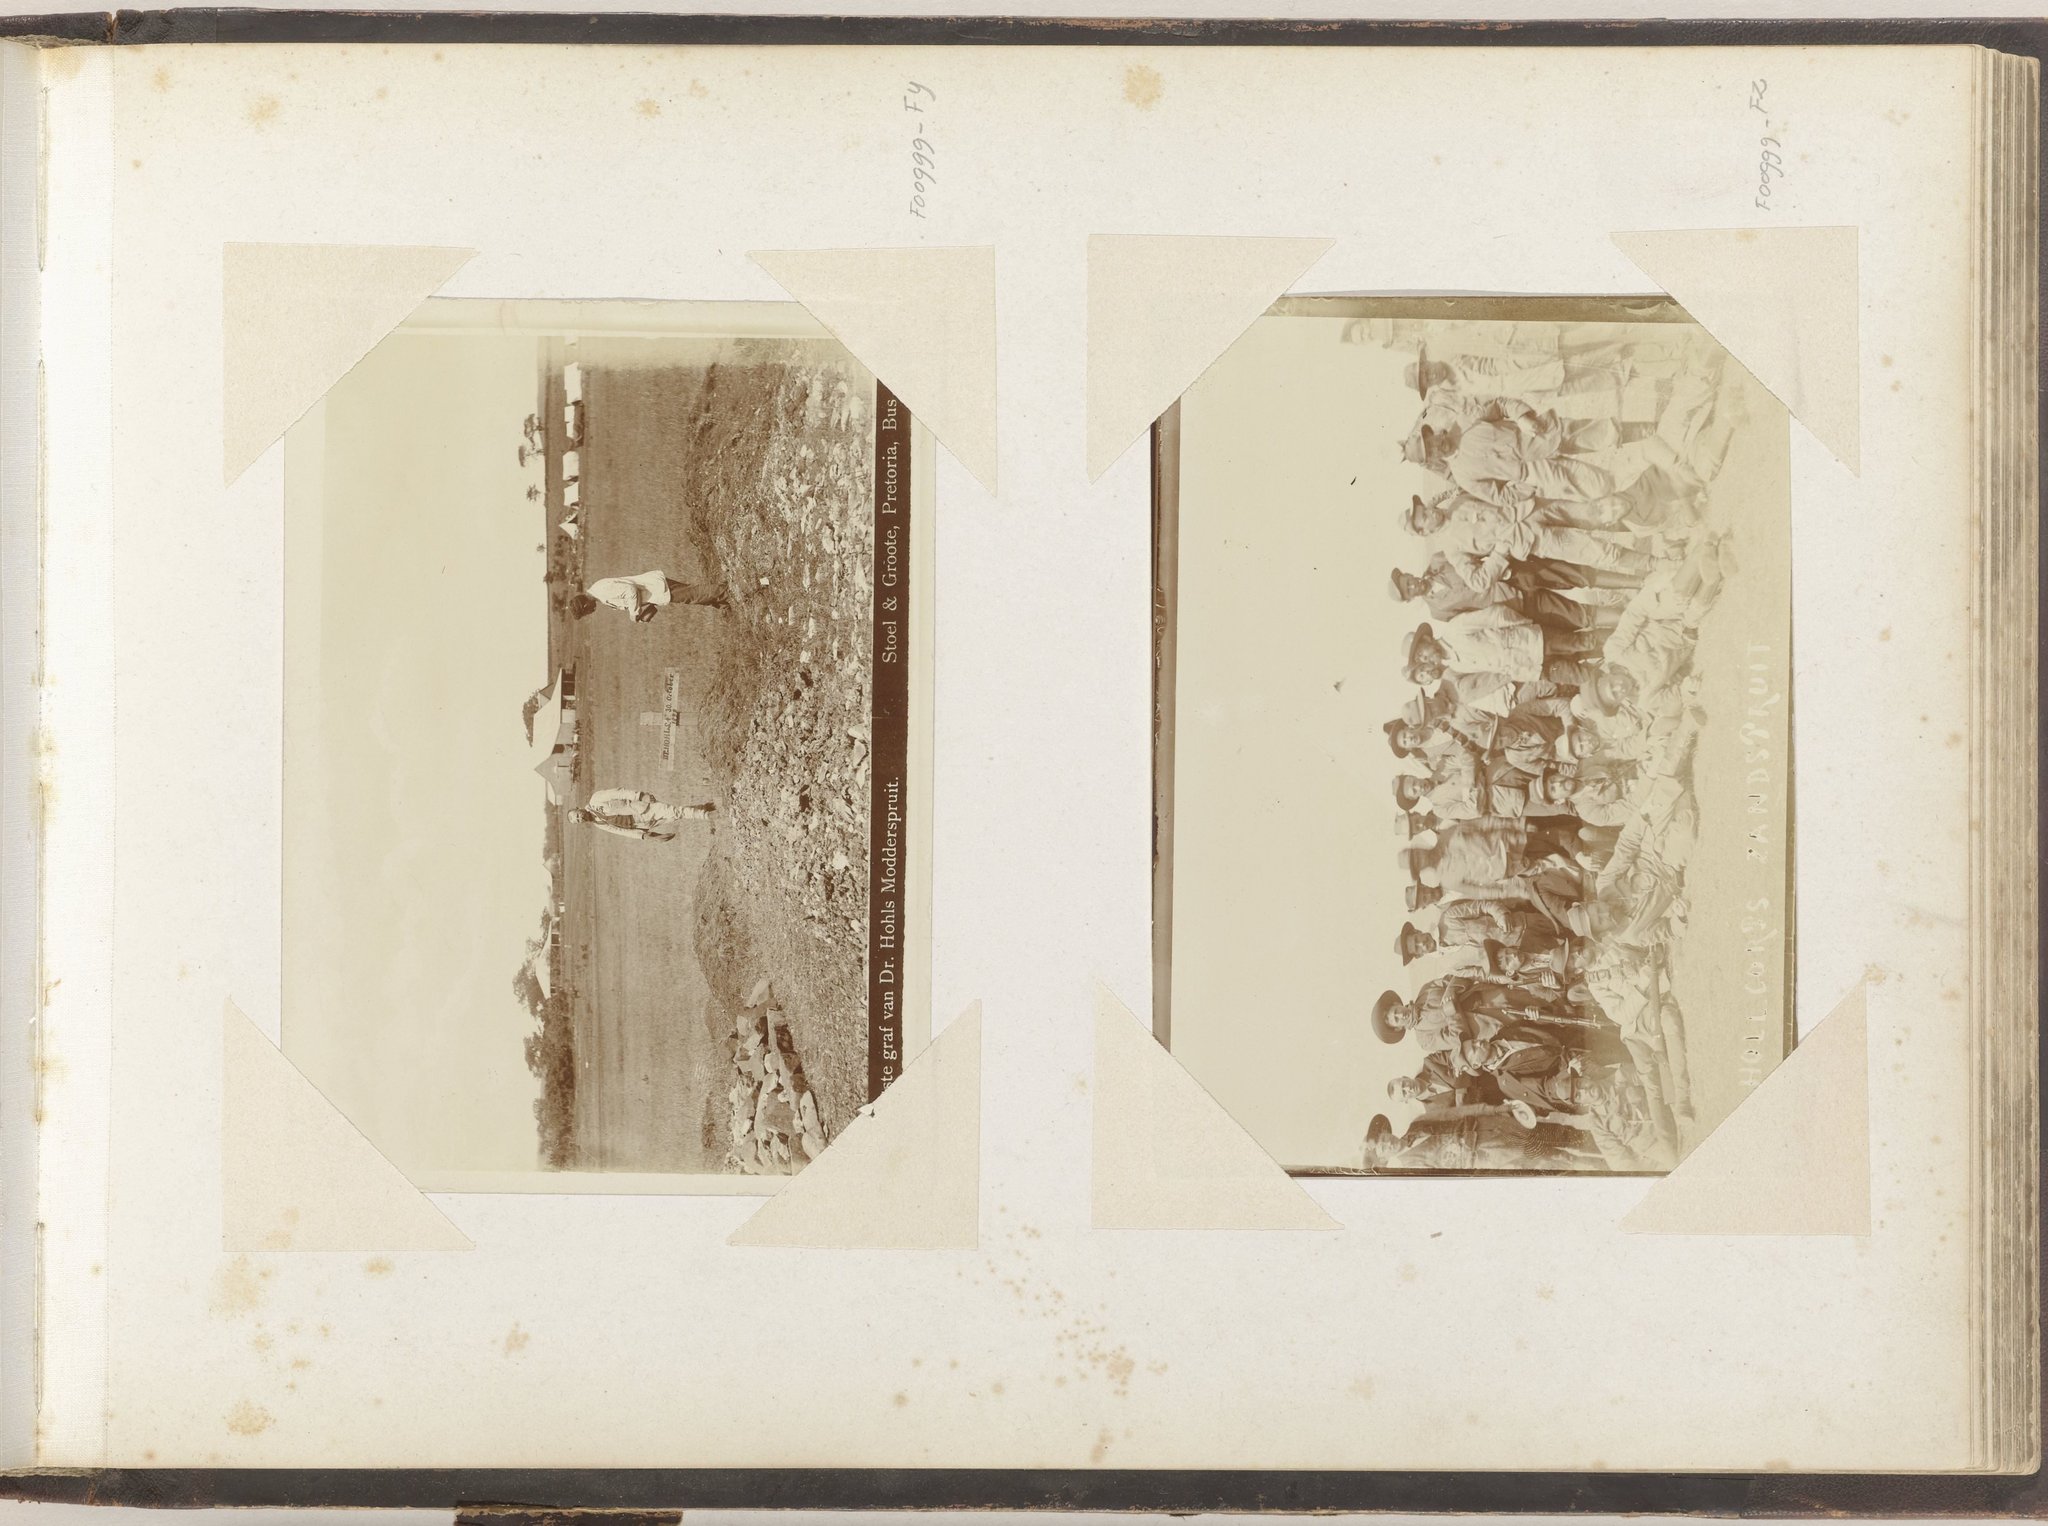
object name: photograph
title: Twee mannen bij het graf van de Duitse geneesheer Hohls in Modderspruit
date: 1899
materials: paper, photographic support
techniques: gelatin silver print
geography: modderspruit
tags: grave, tomb, physician, doctor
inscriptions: inscription: ‘Tent van A. Idenburg waarnemend apotheker der SA Modderspruit 1 november 1899’, negative number: ‘Bus 545’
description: Onderdeel van Album met 191 foto's van een reis naar en door Zuid-Afrika.